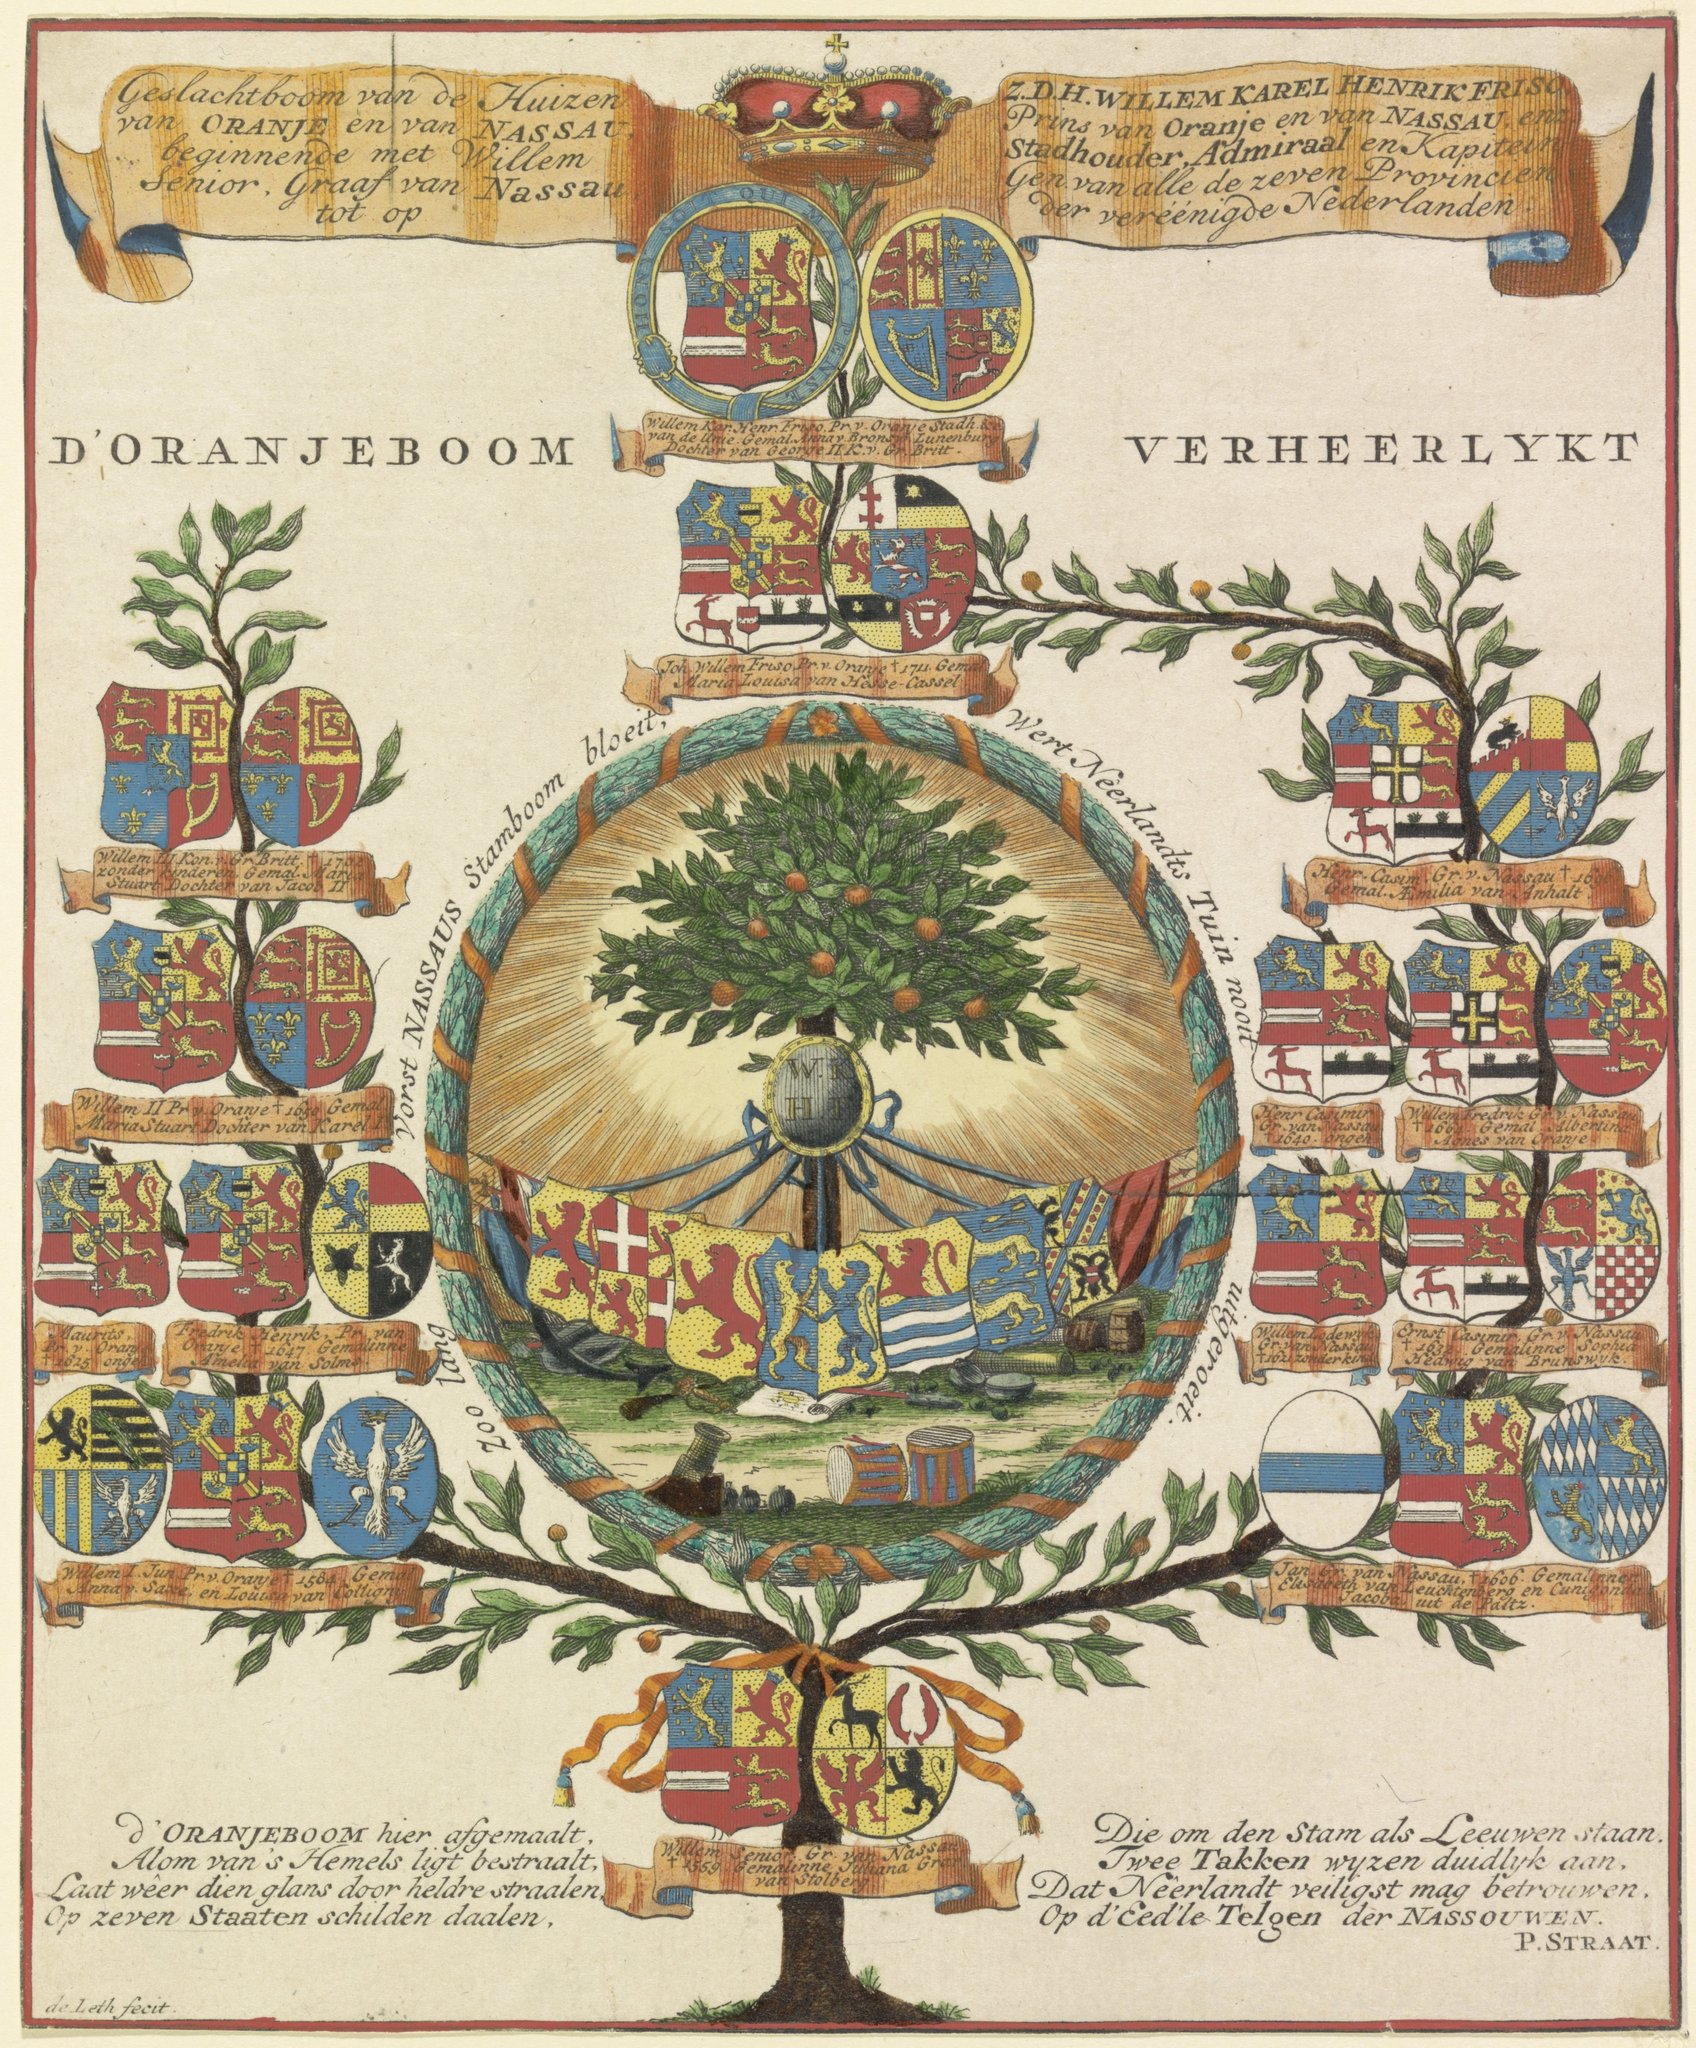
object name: print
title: d'Oranjeboom verheerlykt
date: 1747-1766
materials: paper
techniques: engraving, etching, hand coloring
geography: amsterdam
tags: louise de coligny, william iii (prince of orange and king of england, scotland, and ireland), frederick henry (prince of orange), william ii (prince of orange), delft, william i (prince of orange), maurice (prince of orange), maria ii stuart (koningin van engeland, schotland en ierland), amalia of solms-braunfels, london, mary henrietta stuart, the hague, willem iv (prins van oranje-nassau), anna van hannover, knighthood order (garter) - insignia of a knighthood order, e.g.: badge, chain, family lineage, pedigree, genealogical tree or table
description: Stamboom van het Huis Oranje-Nassau, van Willem I tot en met Willem IV. In het midden de Oranjeboom in een ovaal met randschrift. Aan de stam een plakkaat met de initialen van Willem IV en een aantal wapens. Daar omheen aan de takken van een boom meerdere wapens met in cartouches namen en sterfdata. Linksonder en rechtsonder vier regels Nederlandse tekst.